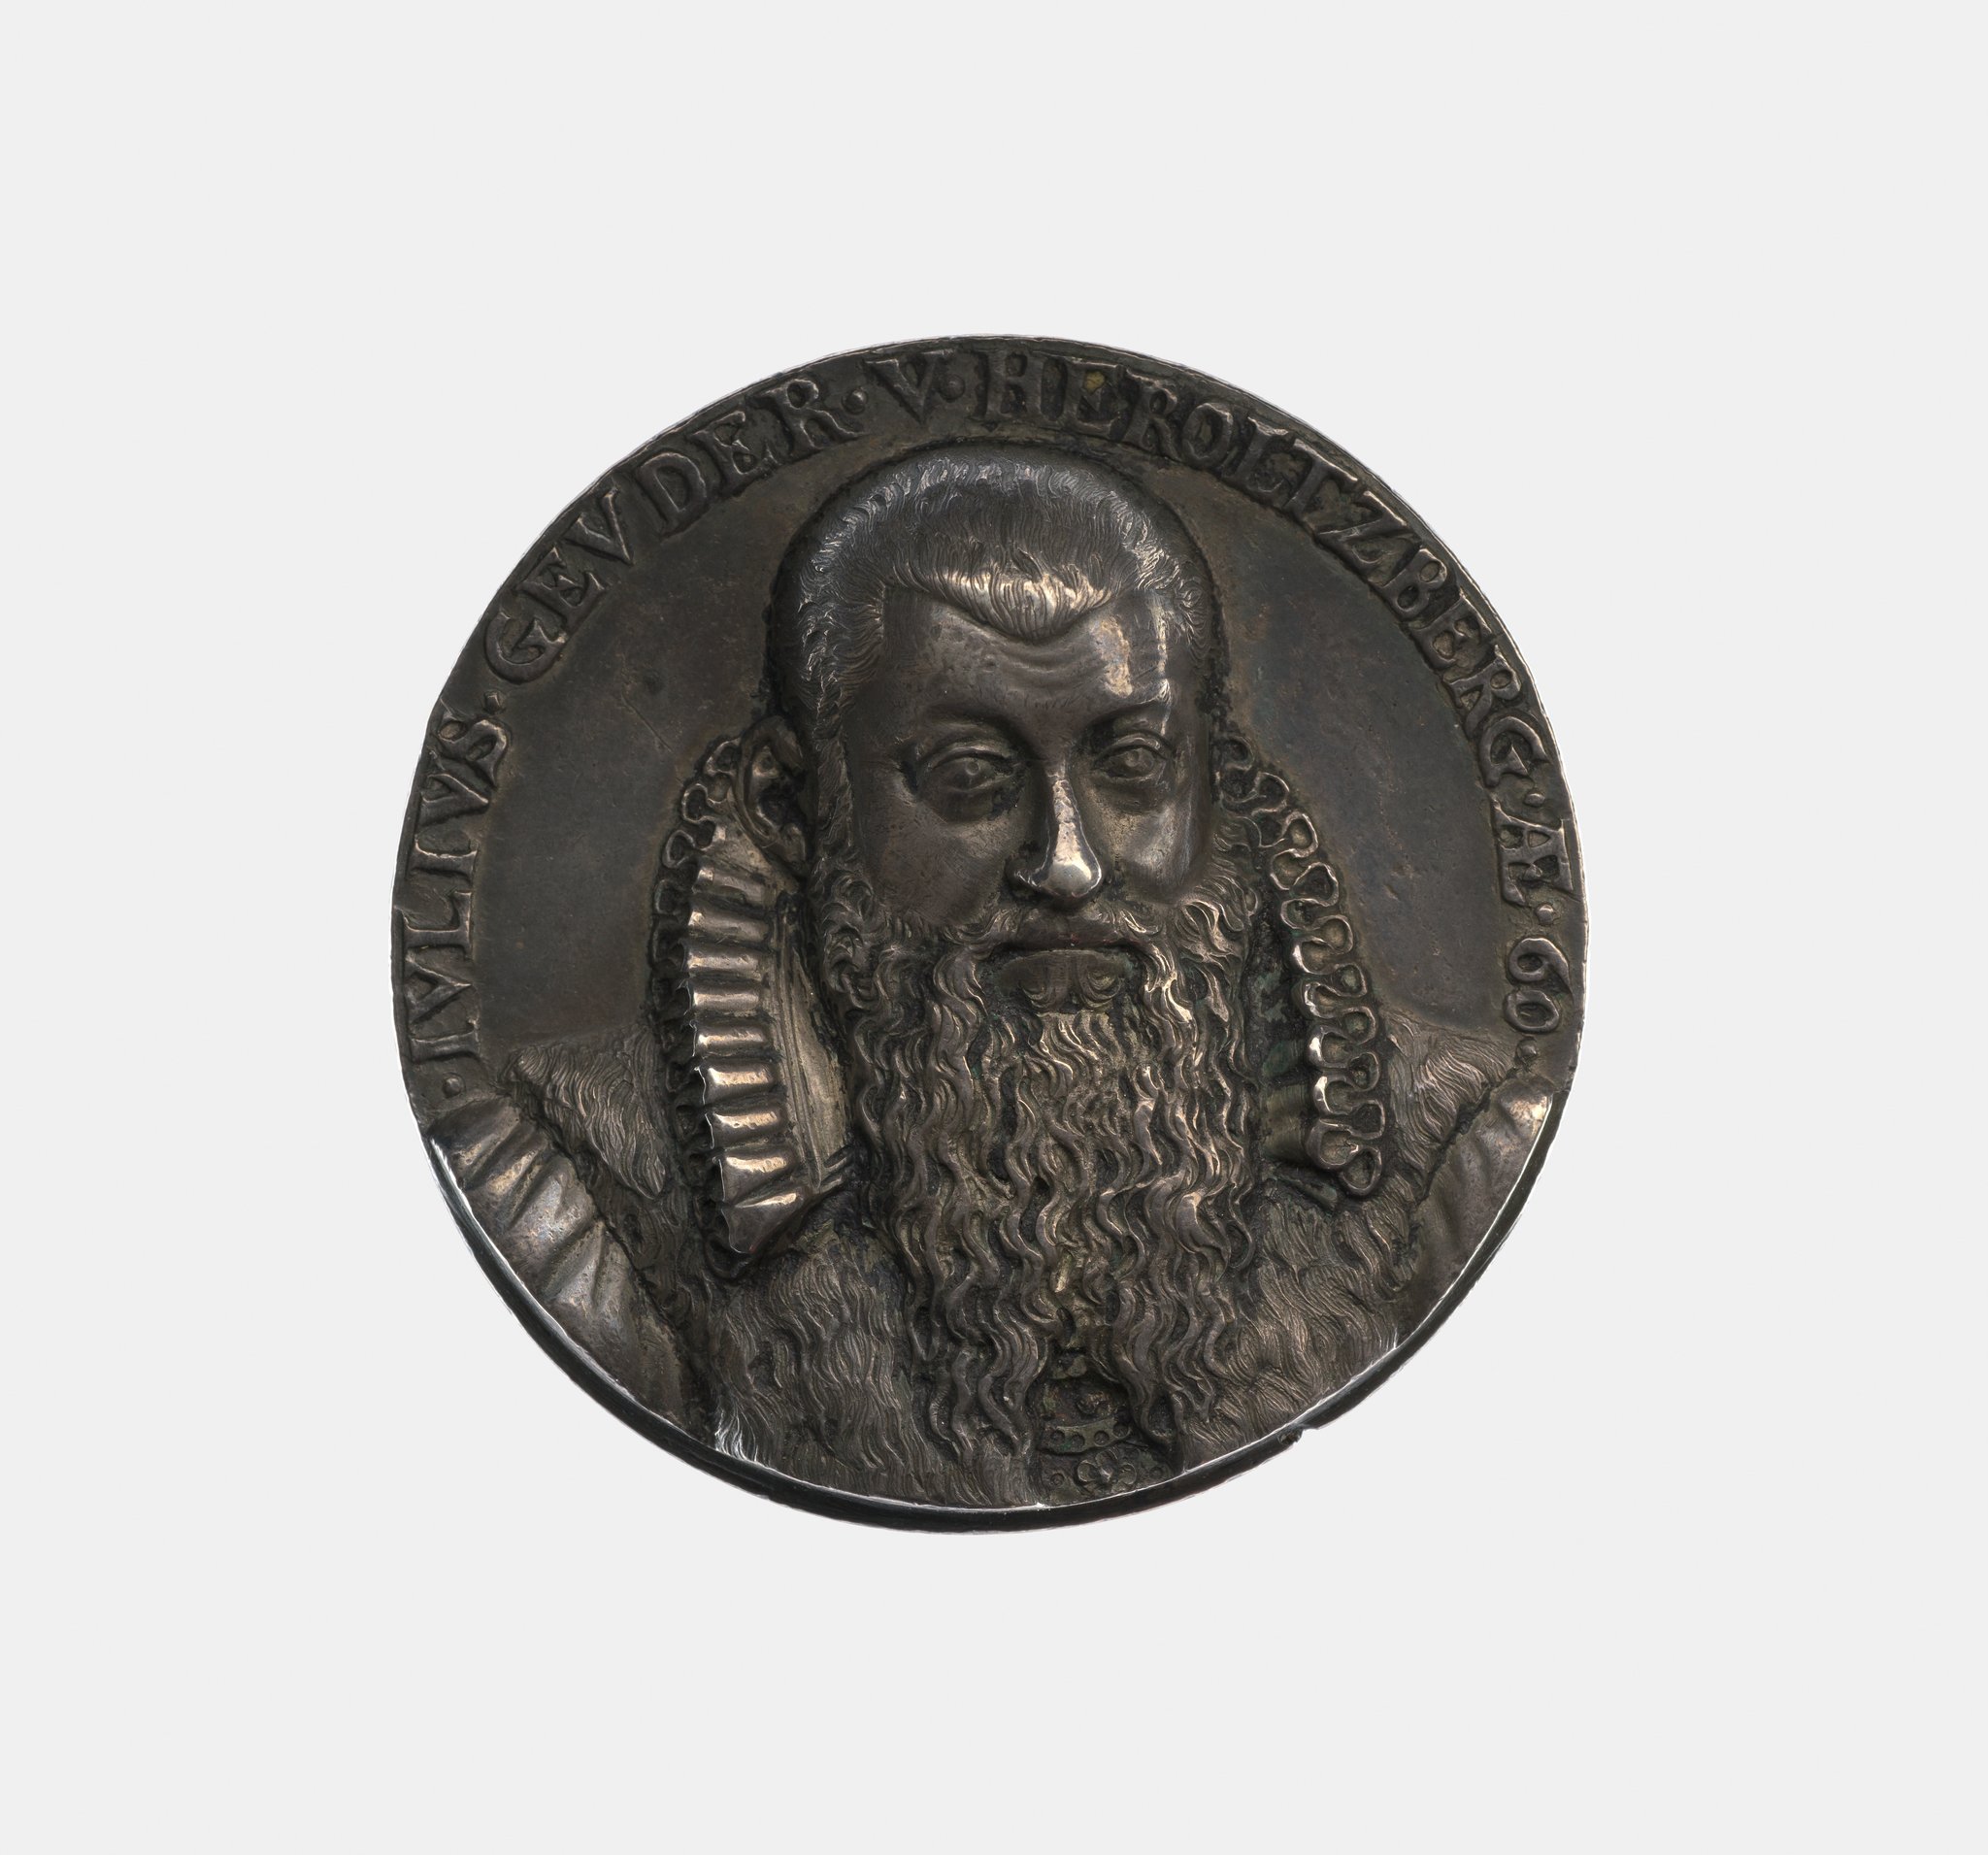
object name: medal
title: Julius Geuder von Heroldsberg (1531–1594)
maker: johann philipp von der pütt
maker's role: artist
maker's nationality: german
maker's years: 1560-1624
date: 1591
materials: silver